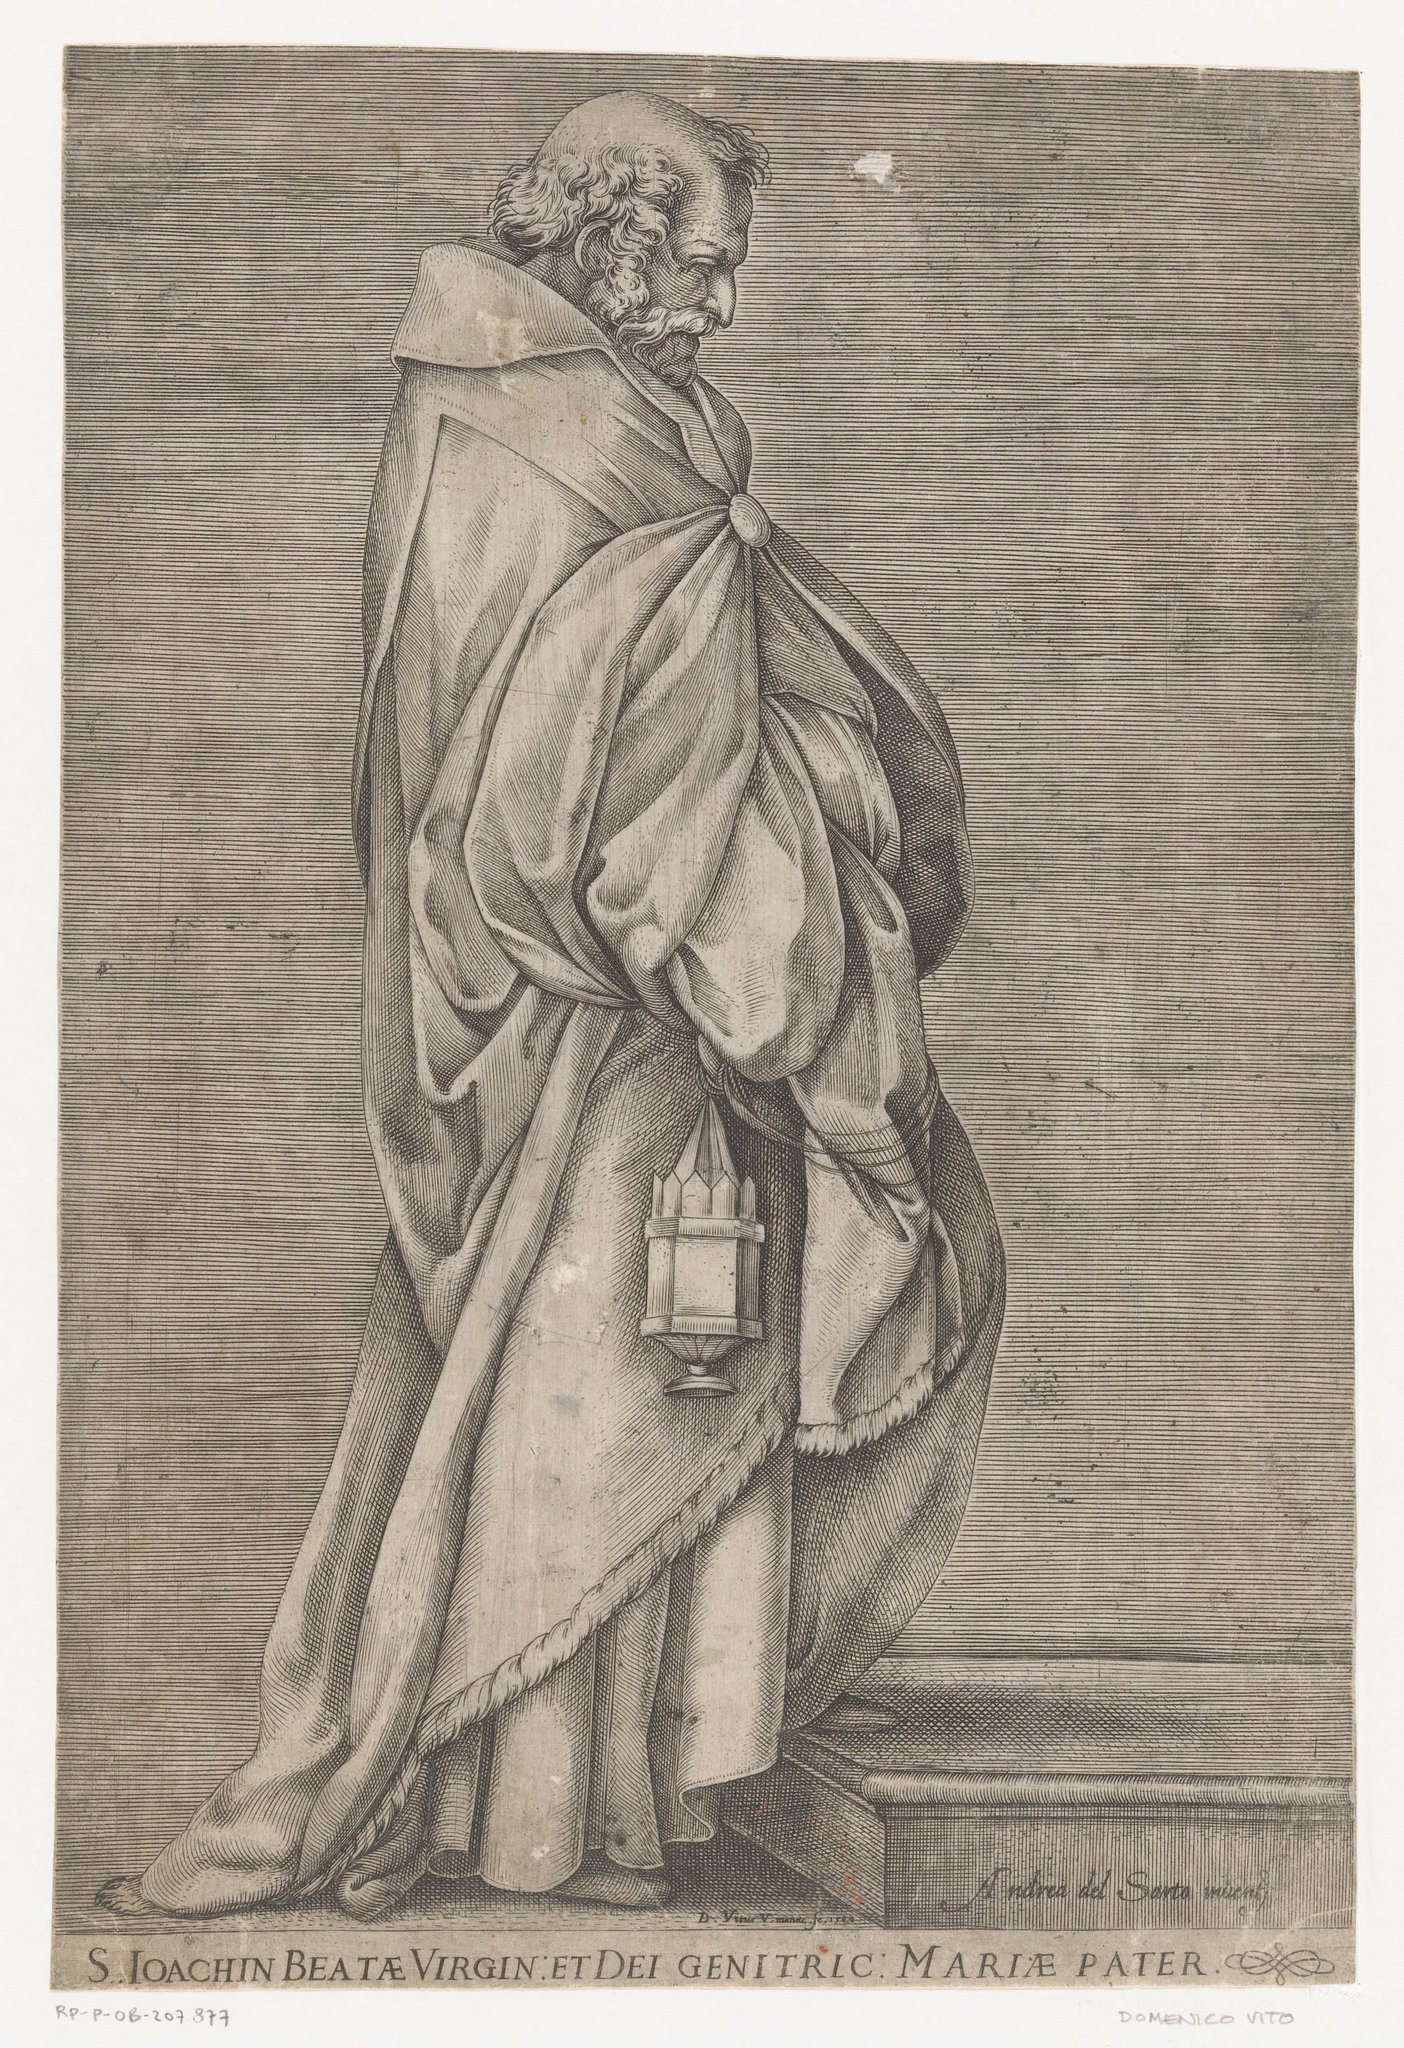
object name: print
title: Heilige Joachim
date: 1580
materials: paper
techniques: engraving, intaglio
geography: italy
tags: the father of mary, joachim; possible attributes: book, two doves, lamb, (shepherd's) staff, annunciation of the birth of john the baptist to zacharias: while he is offering incense in the temple an angel (gabriel) appears to him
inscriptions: collector's mark: Lugt 2228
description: De hogepriester Zacharias met wierookvat. Aan Zacharias werd door de aartsengel Gabriël de geboorte van Johannes de Doper voorspeld. De engel verscheen aan Zacharias op het moment dat hij wierook offerde in de tempel. In de ondermarge wordt de figuur foutief geïdentificeerd als de Heilige Joachim, de vader van Maria.